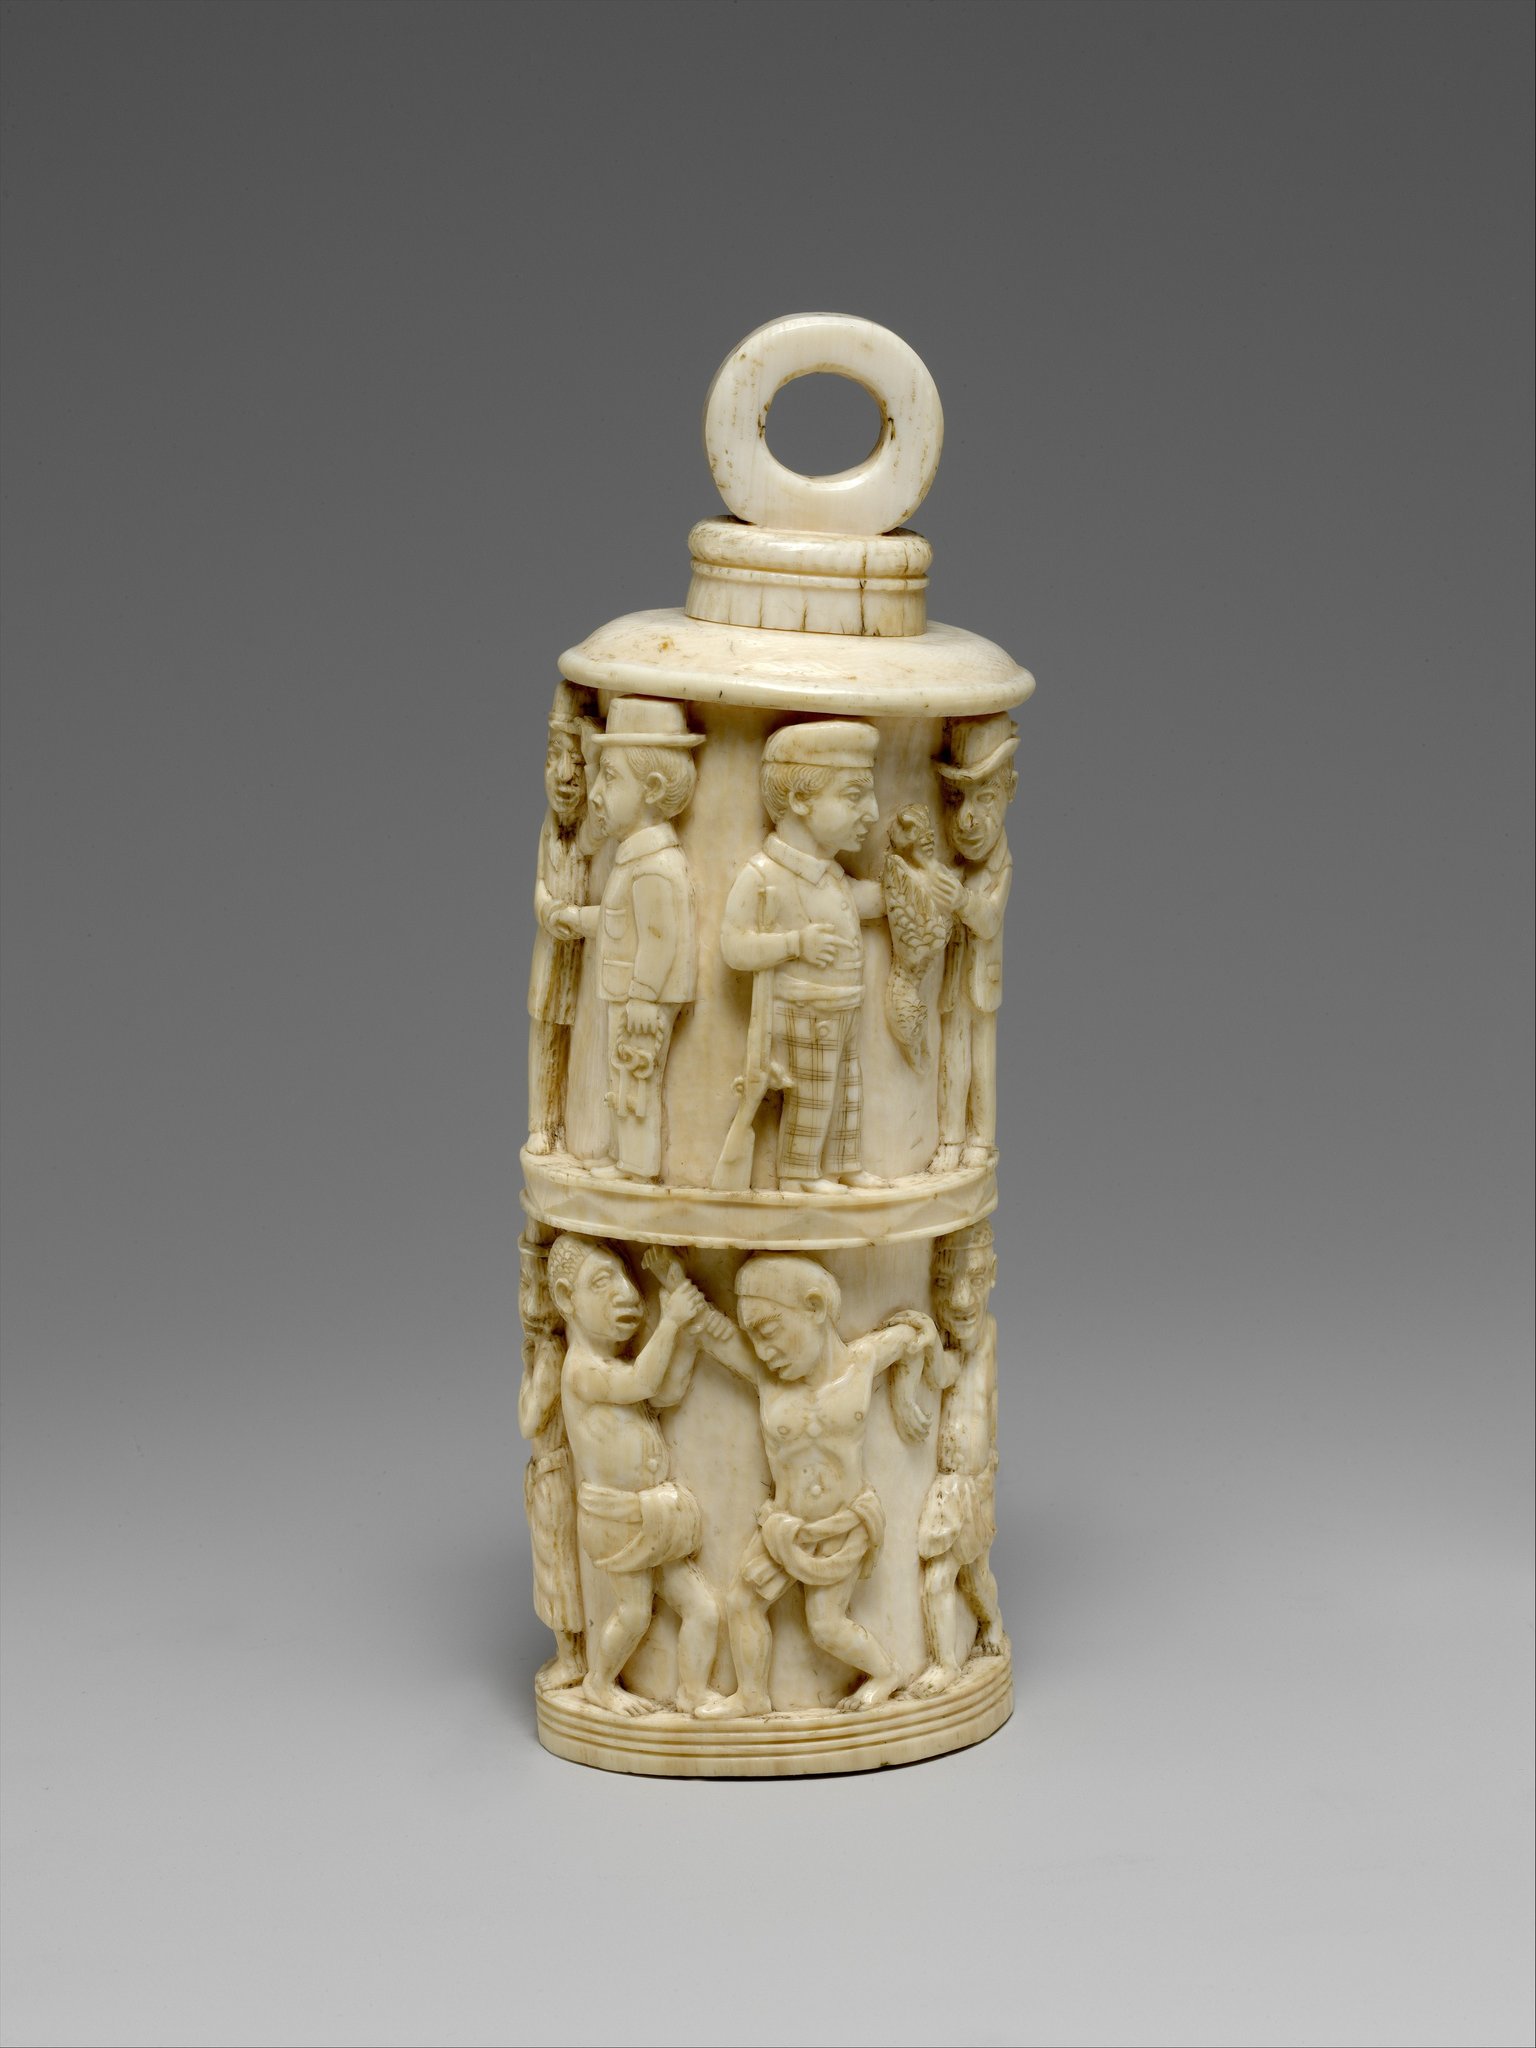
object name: vessel with stopper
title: Receptacle with Figurative Relief and Stopper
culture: kongo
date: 1880-1890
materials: ivory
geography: democratic republic of the congo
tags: men